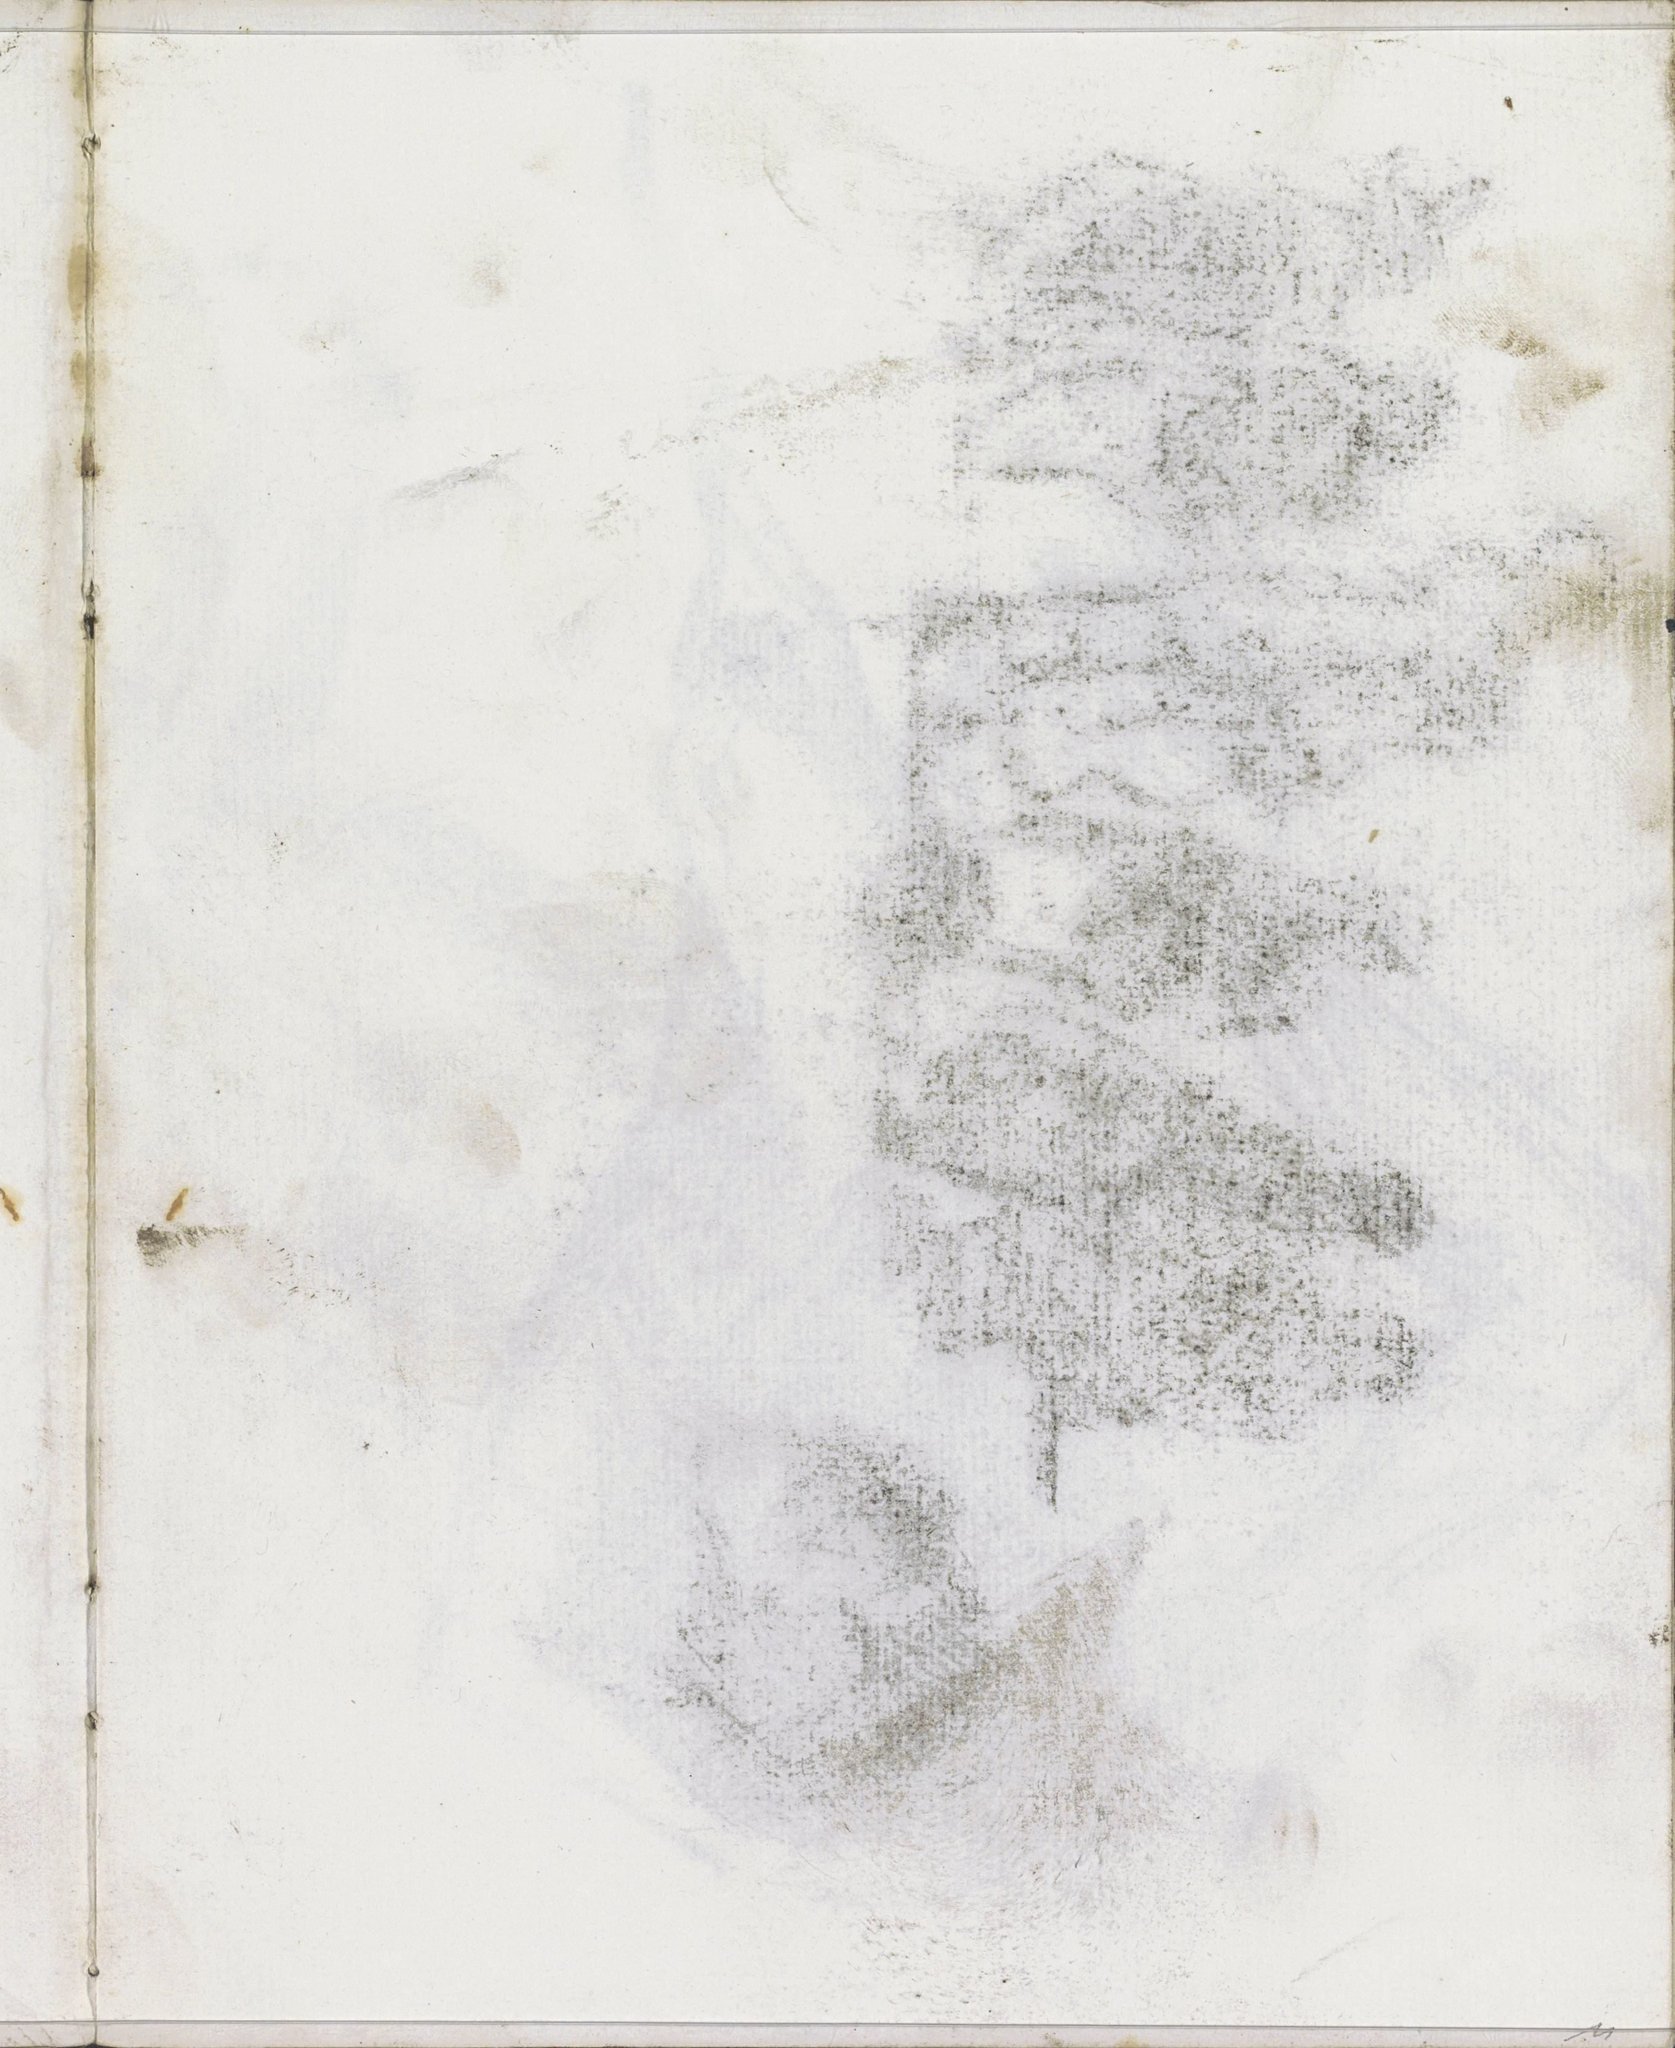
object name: sketchbook leaf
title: Abklatsch van de krijttekening op blad 10 verso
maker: isaac israels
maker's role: draughtsman, painter, print maker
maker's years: 1865-1934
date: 1875-1934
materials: paper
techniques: printmaking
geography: the hague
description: Blad 11 recto uit schetsboek XIII met 25 bladen.